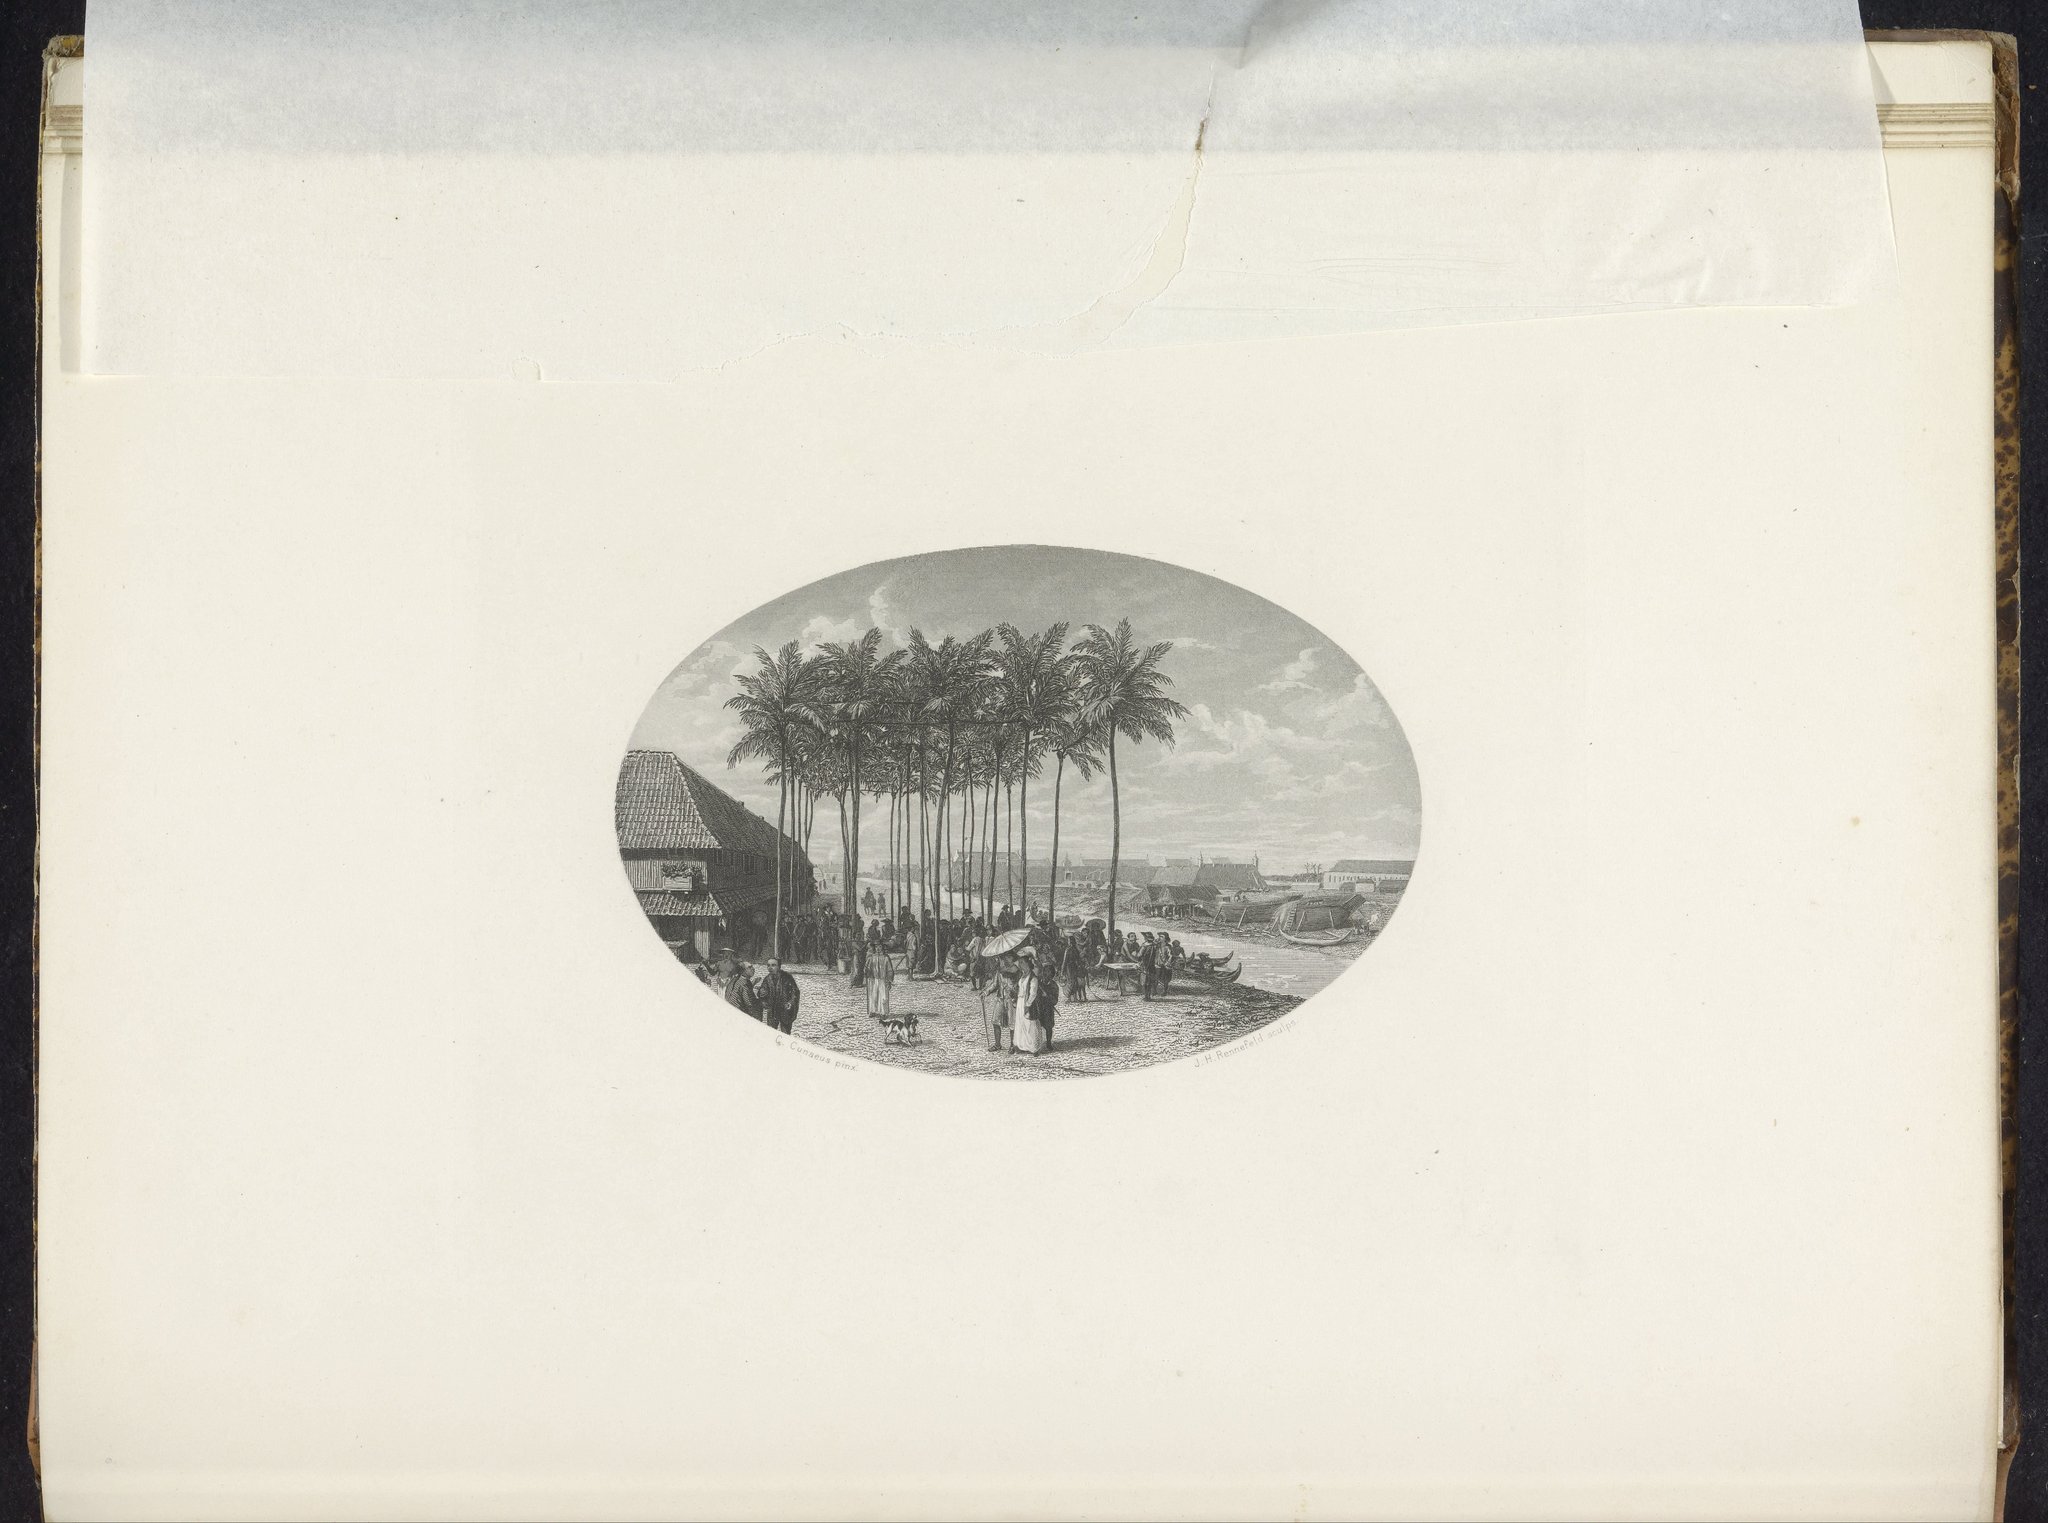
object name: history print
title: Stichting van Batavia, 1619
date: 1865-1870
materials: paper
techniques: engraving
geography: netherlands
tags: city founding, batavia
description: De stichting van Batavia op Java door de VOC in 1619. Onderdeel van de groep staalgravures naar de schilderijen van de Historische Galerij der Maatschappij Arti et Amicitiae.